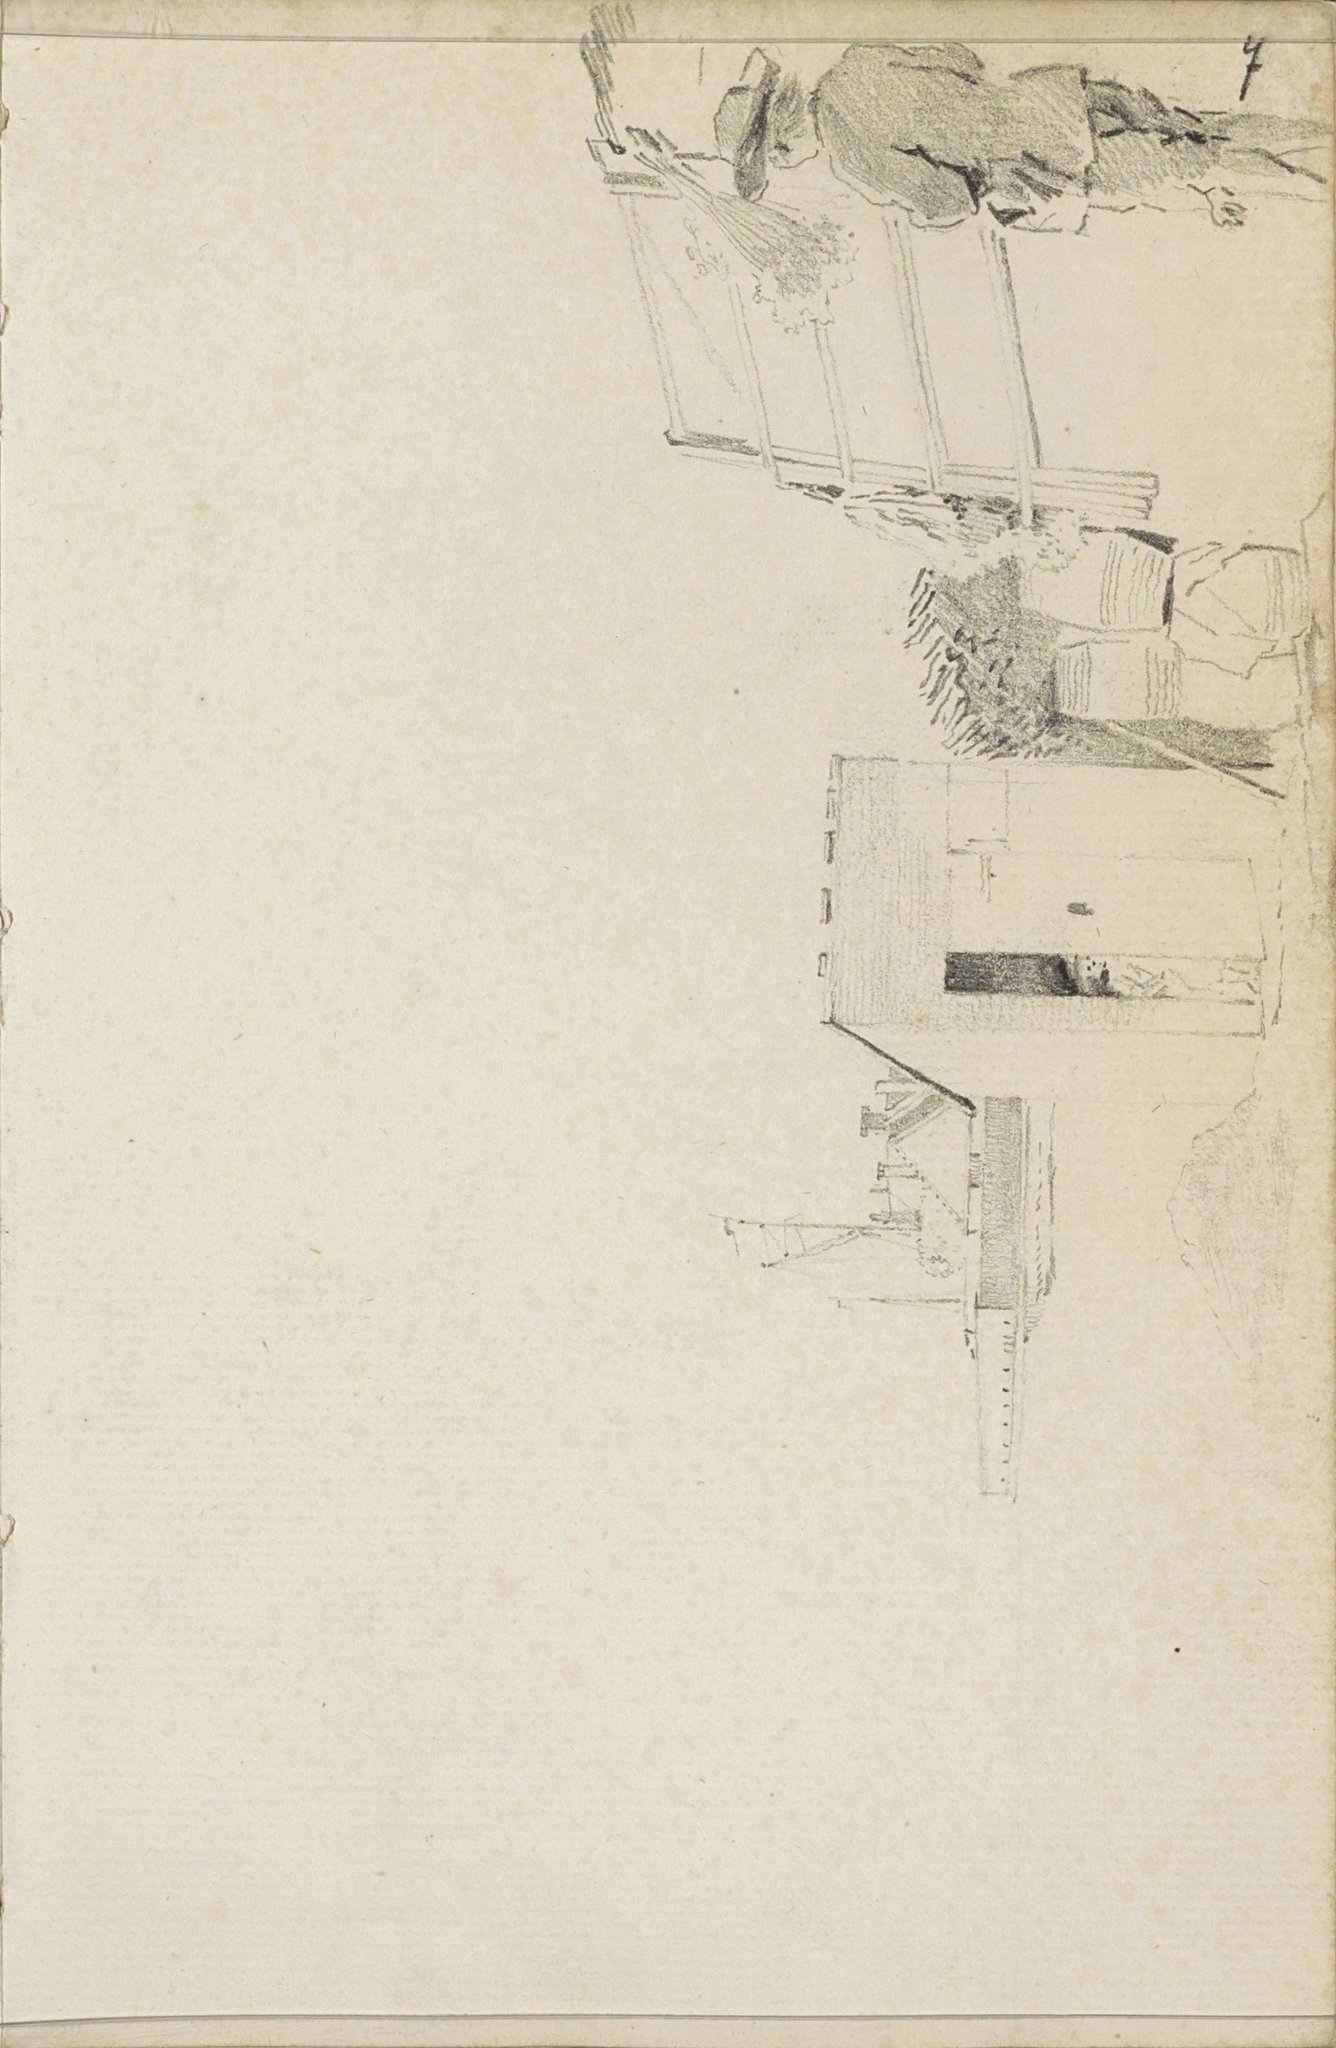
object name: sketchbook leaf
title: Studieblad, onder andere met een hek, tonnen, bossen graan en figuren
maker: jacob perkois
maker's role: draughtsman, print maker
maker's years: 1756-1804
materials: paper, pencil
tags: standing figure, wooden container: barrel, cask, bucket, kinds of flower or grain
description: Bladzijde 7 uit een schetsboek met 78 bladzijden.